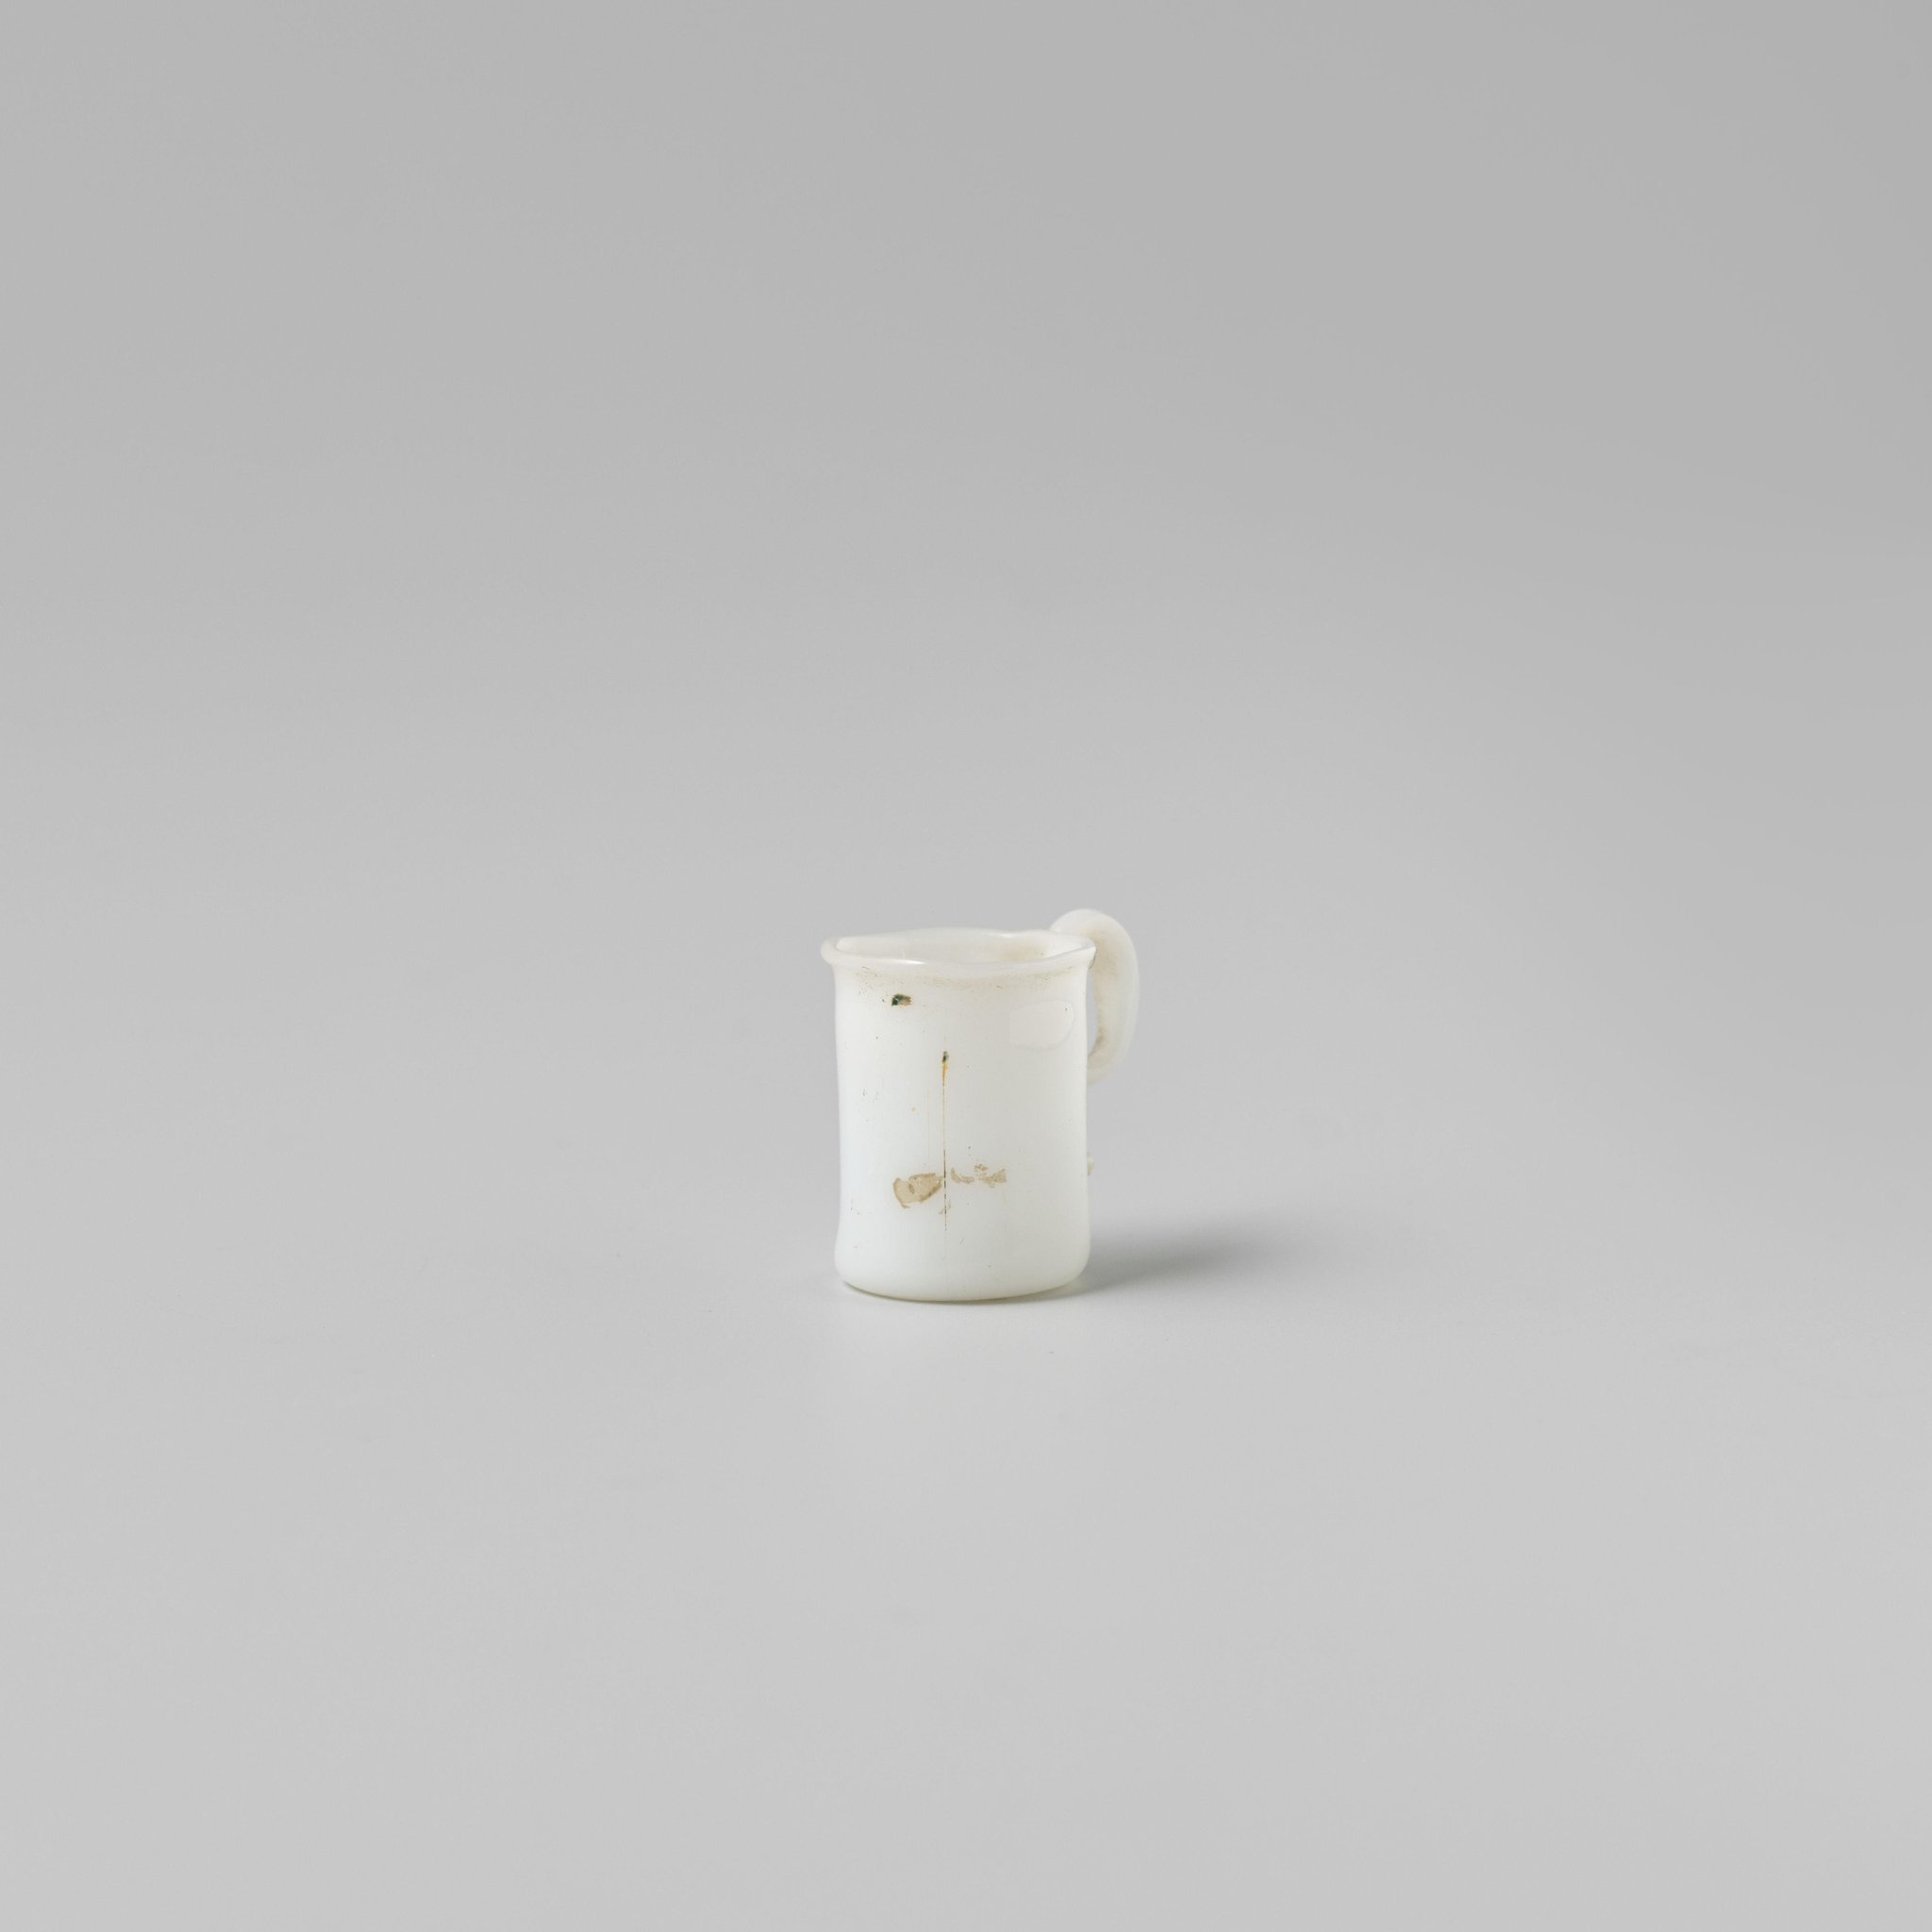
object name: cup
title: Kop met oor, beschilderd met bloem in wit, rood en groen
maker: Anonymous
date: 1800-1849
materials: glass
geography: bristol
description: Kop van opaak wit glas, cilindrisch, met s-vormig oor. De kop is beschilderd met een bloem in wit, rood en groen.